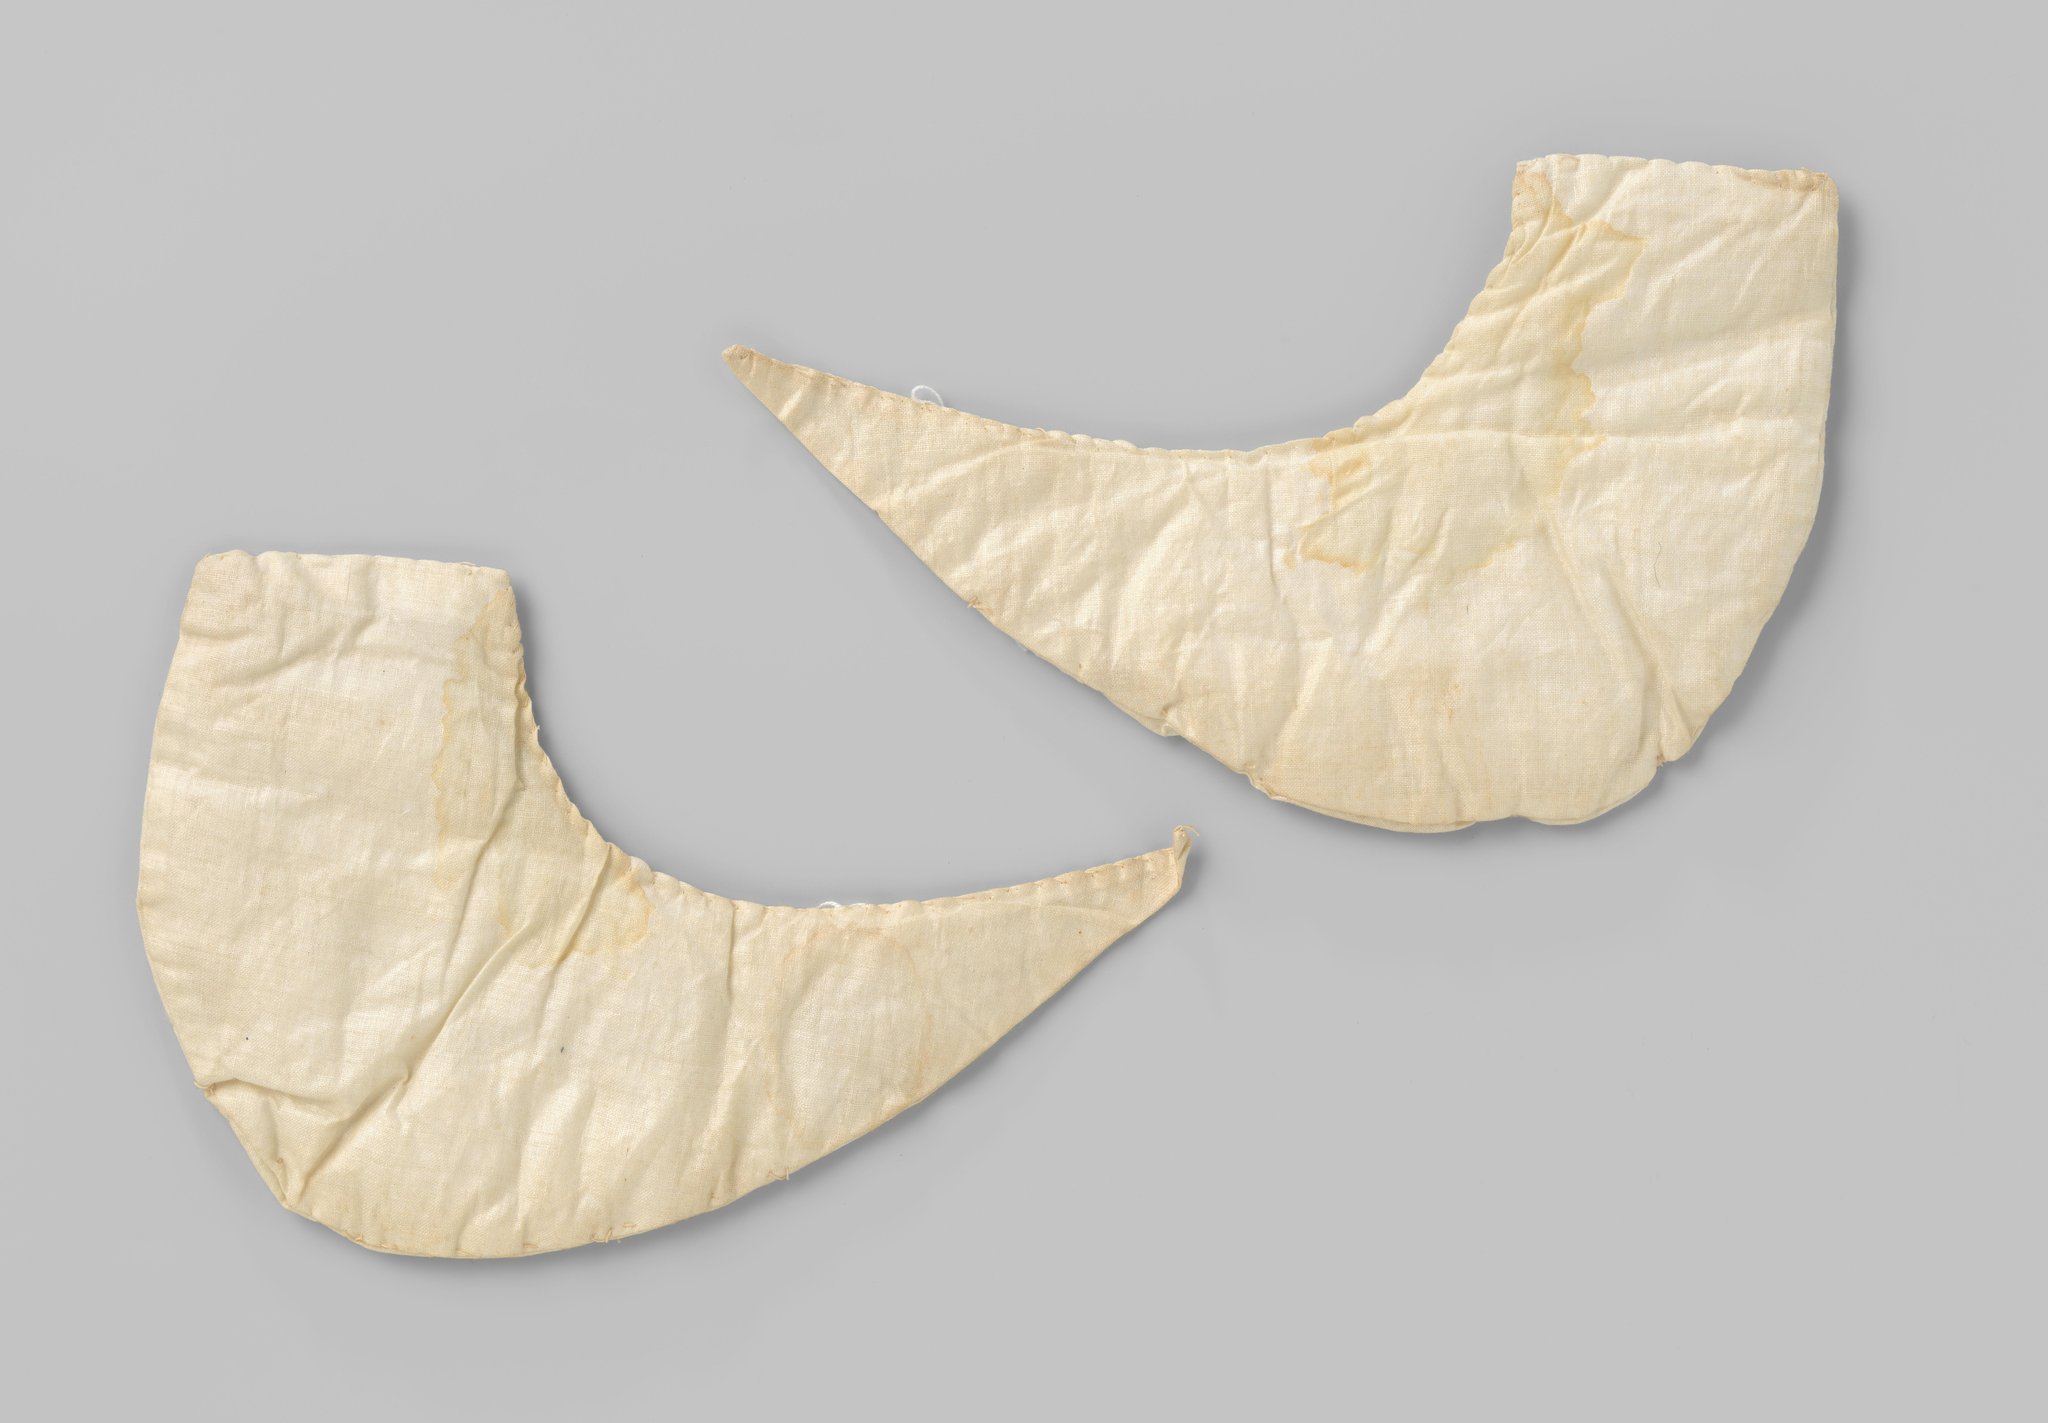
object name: cushion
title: Kussen in de vorm van een halve maan van wit glanzend katoen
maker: Anonymous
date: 1880-1930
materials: cotton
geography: europe